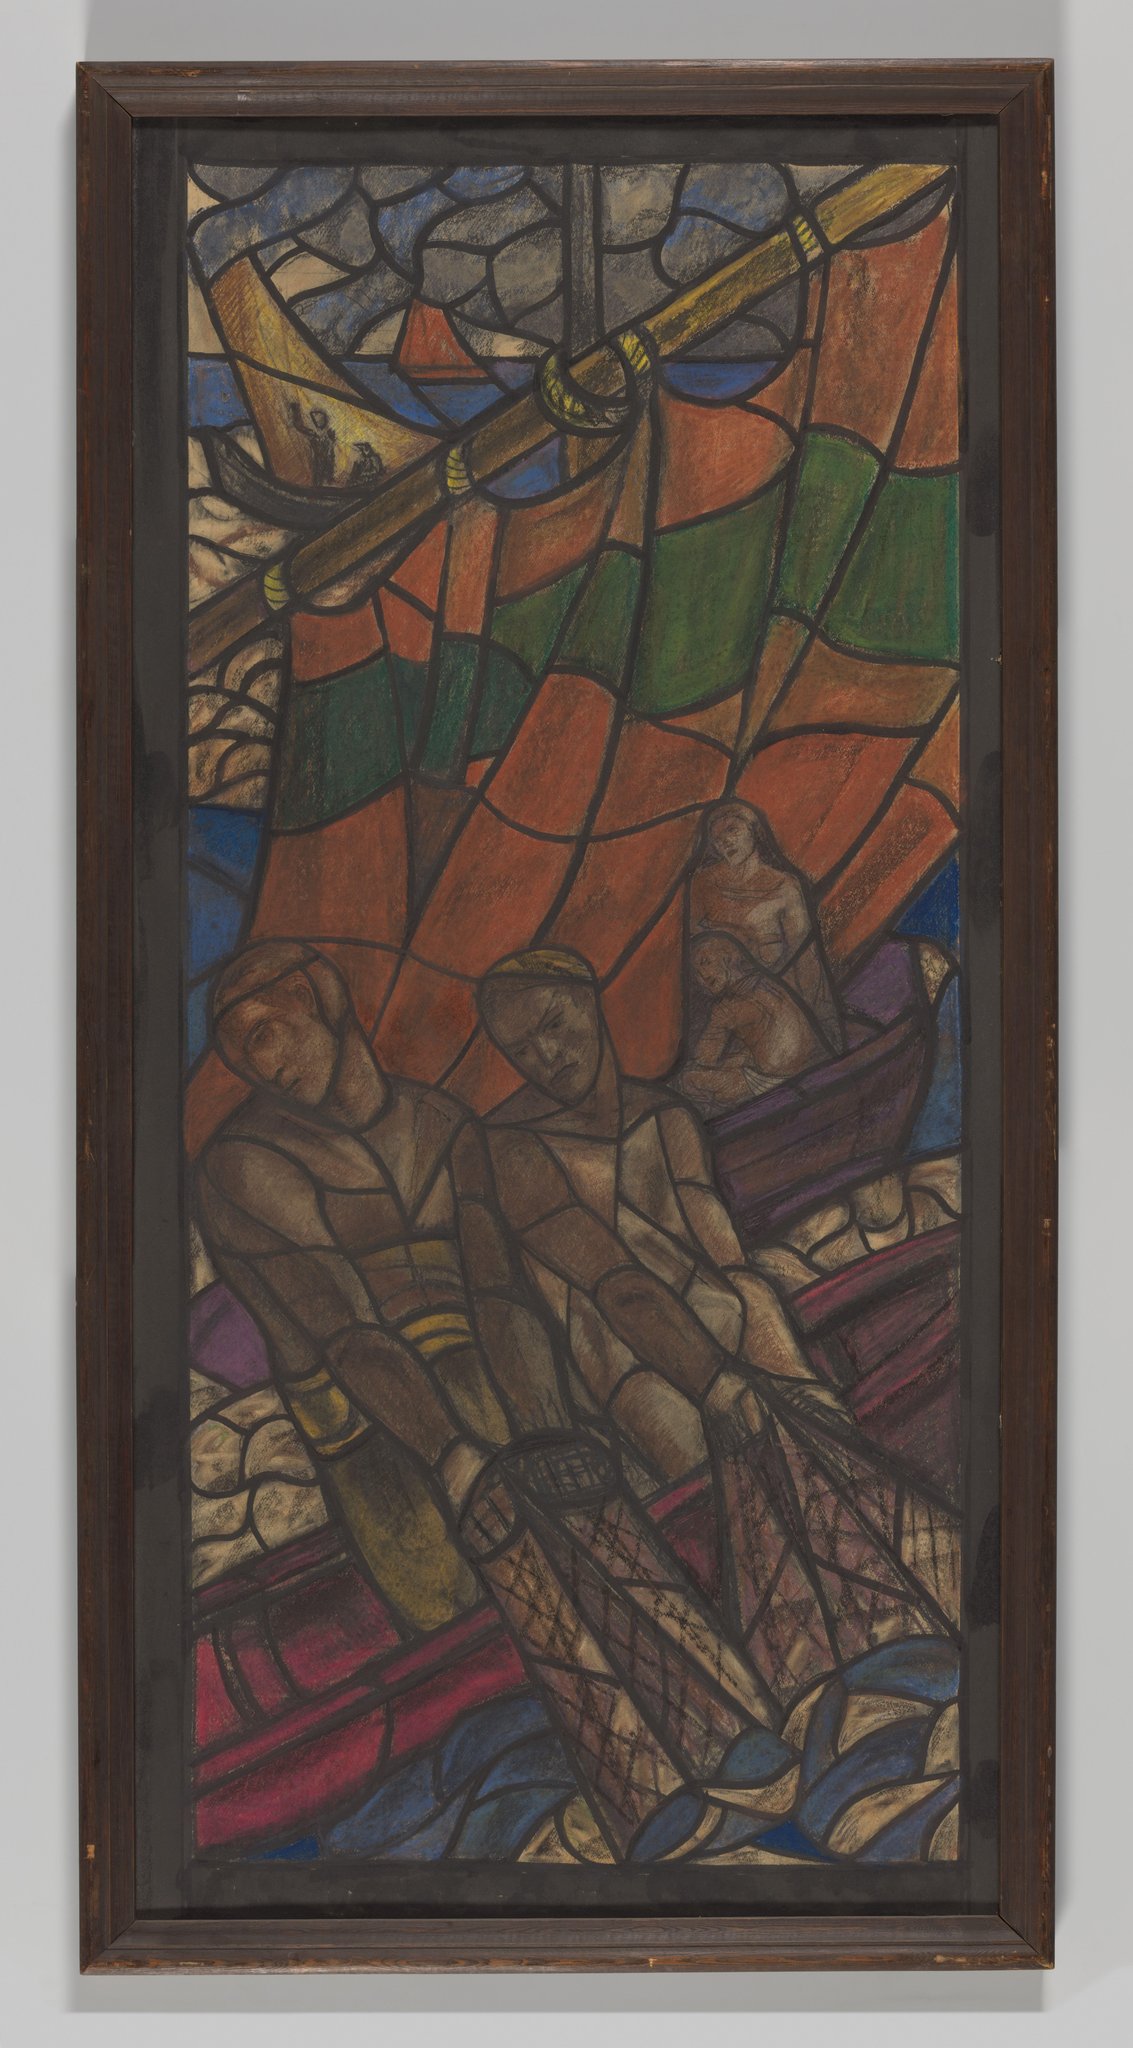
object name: drawing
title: Ontwerp voor raam in het Stadhuis in Amsterdam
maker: richard nicolaüs roland holst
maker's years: 1868-1938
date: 1868-1938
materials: cardboard, chalk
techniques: brush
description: Dijkenbouwers, Vissers en Verdediging in van de stad.